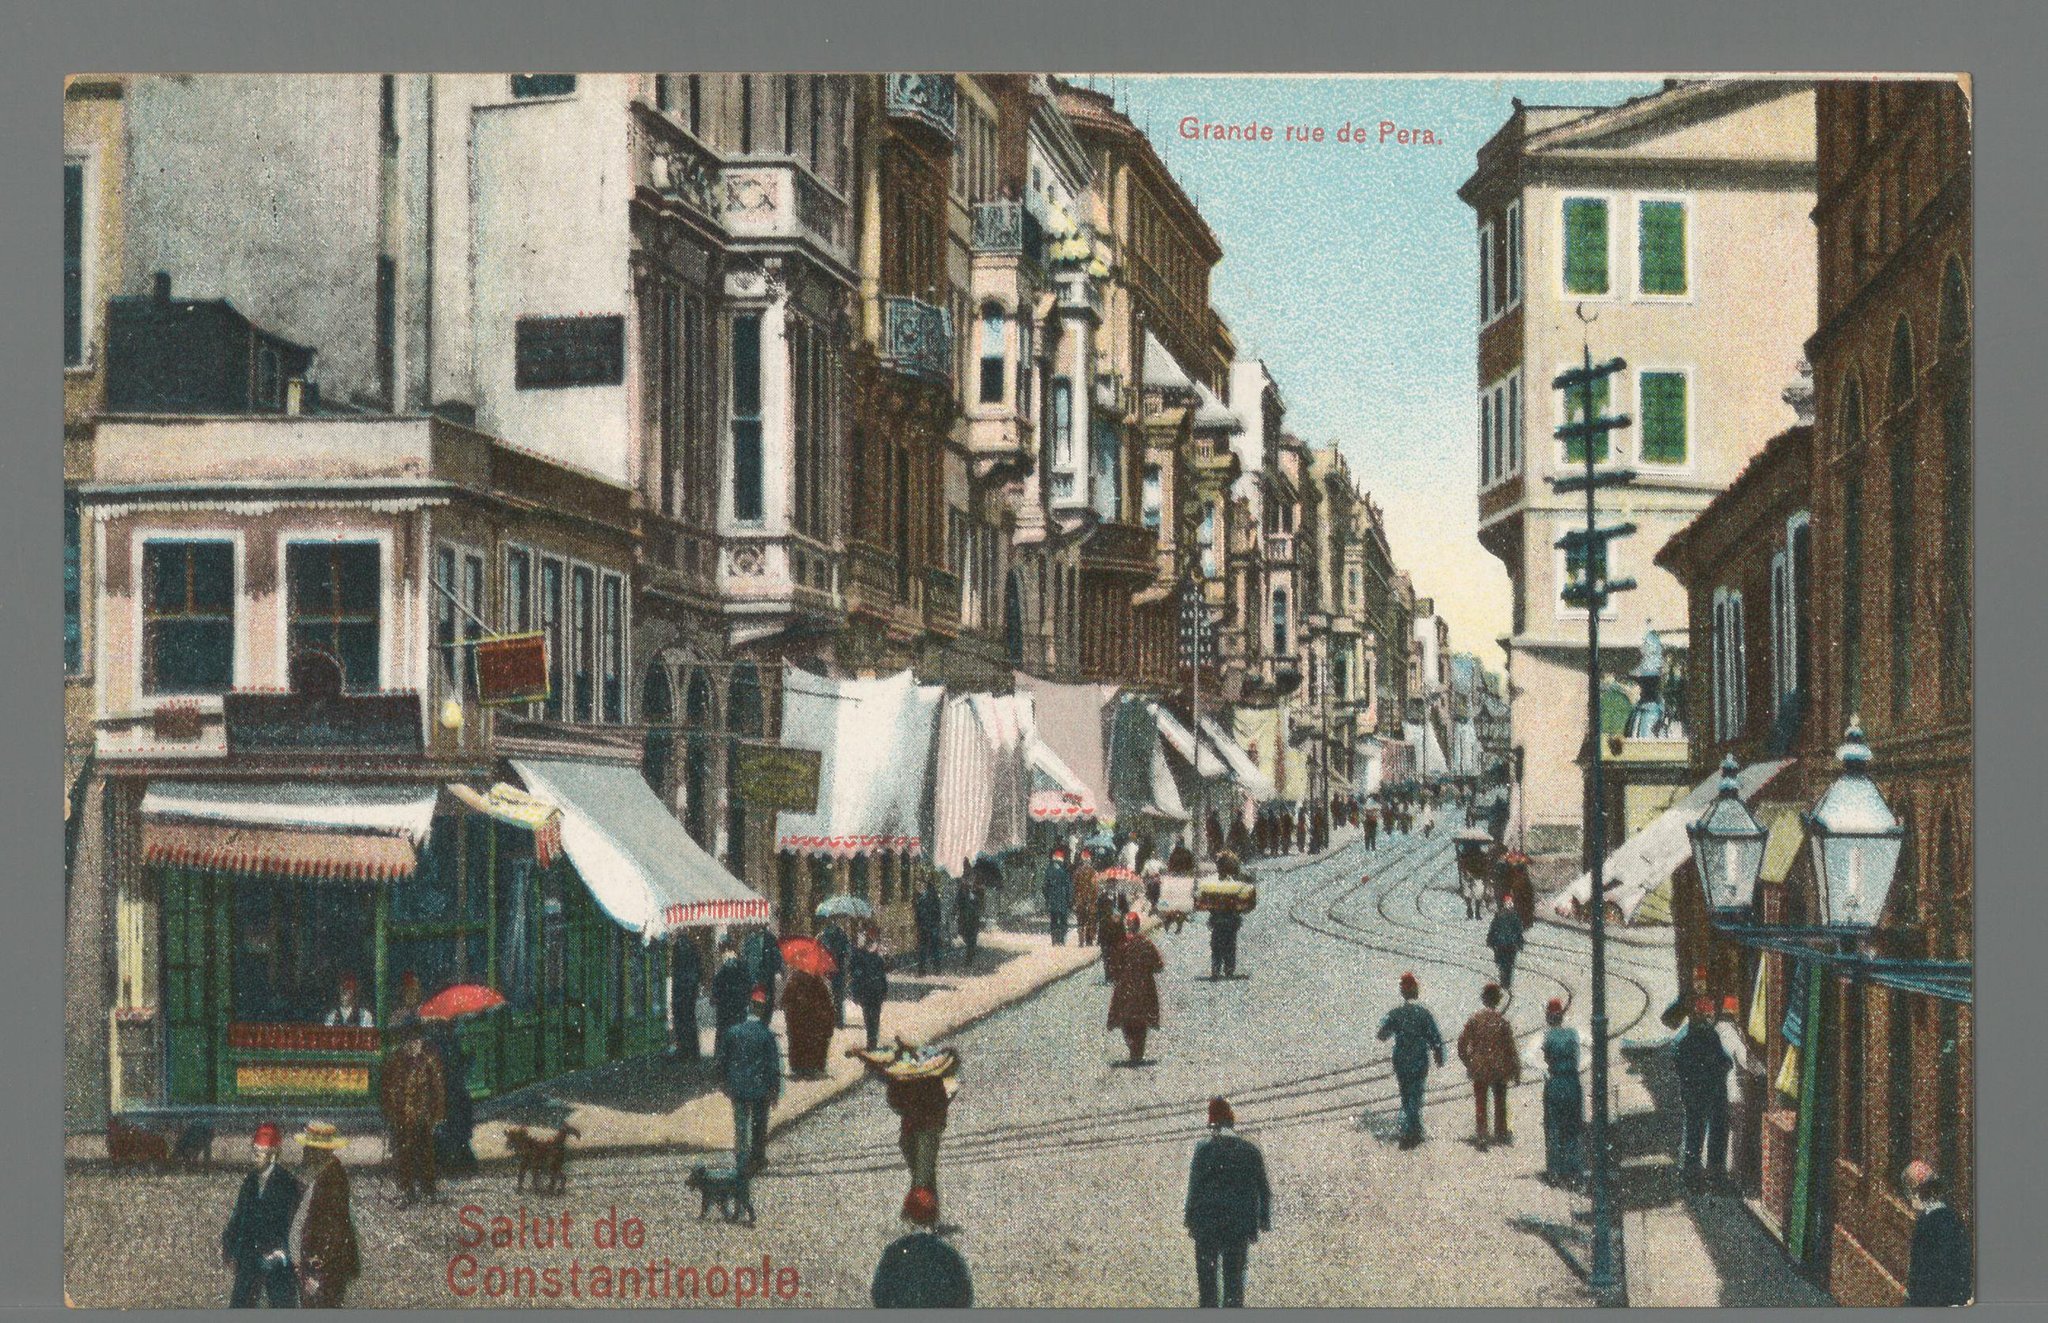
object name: photomechanical print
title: Grande rue de Pera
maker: Anonymous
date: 1906-1920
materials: cardboard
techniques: lithograph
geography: constantinople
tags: tramway, tram, city-view, and landscape with man-made constructions (+ city(-scape) with figures, staffage)